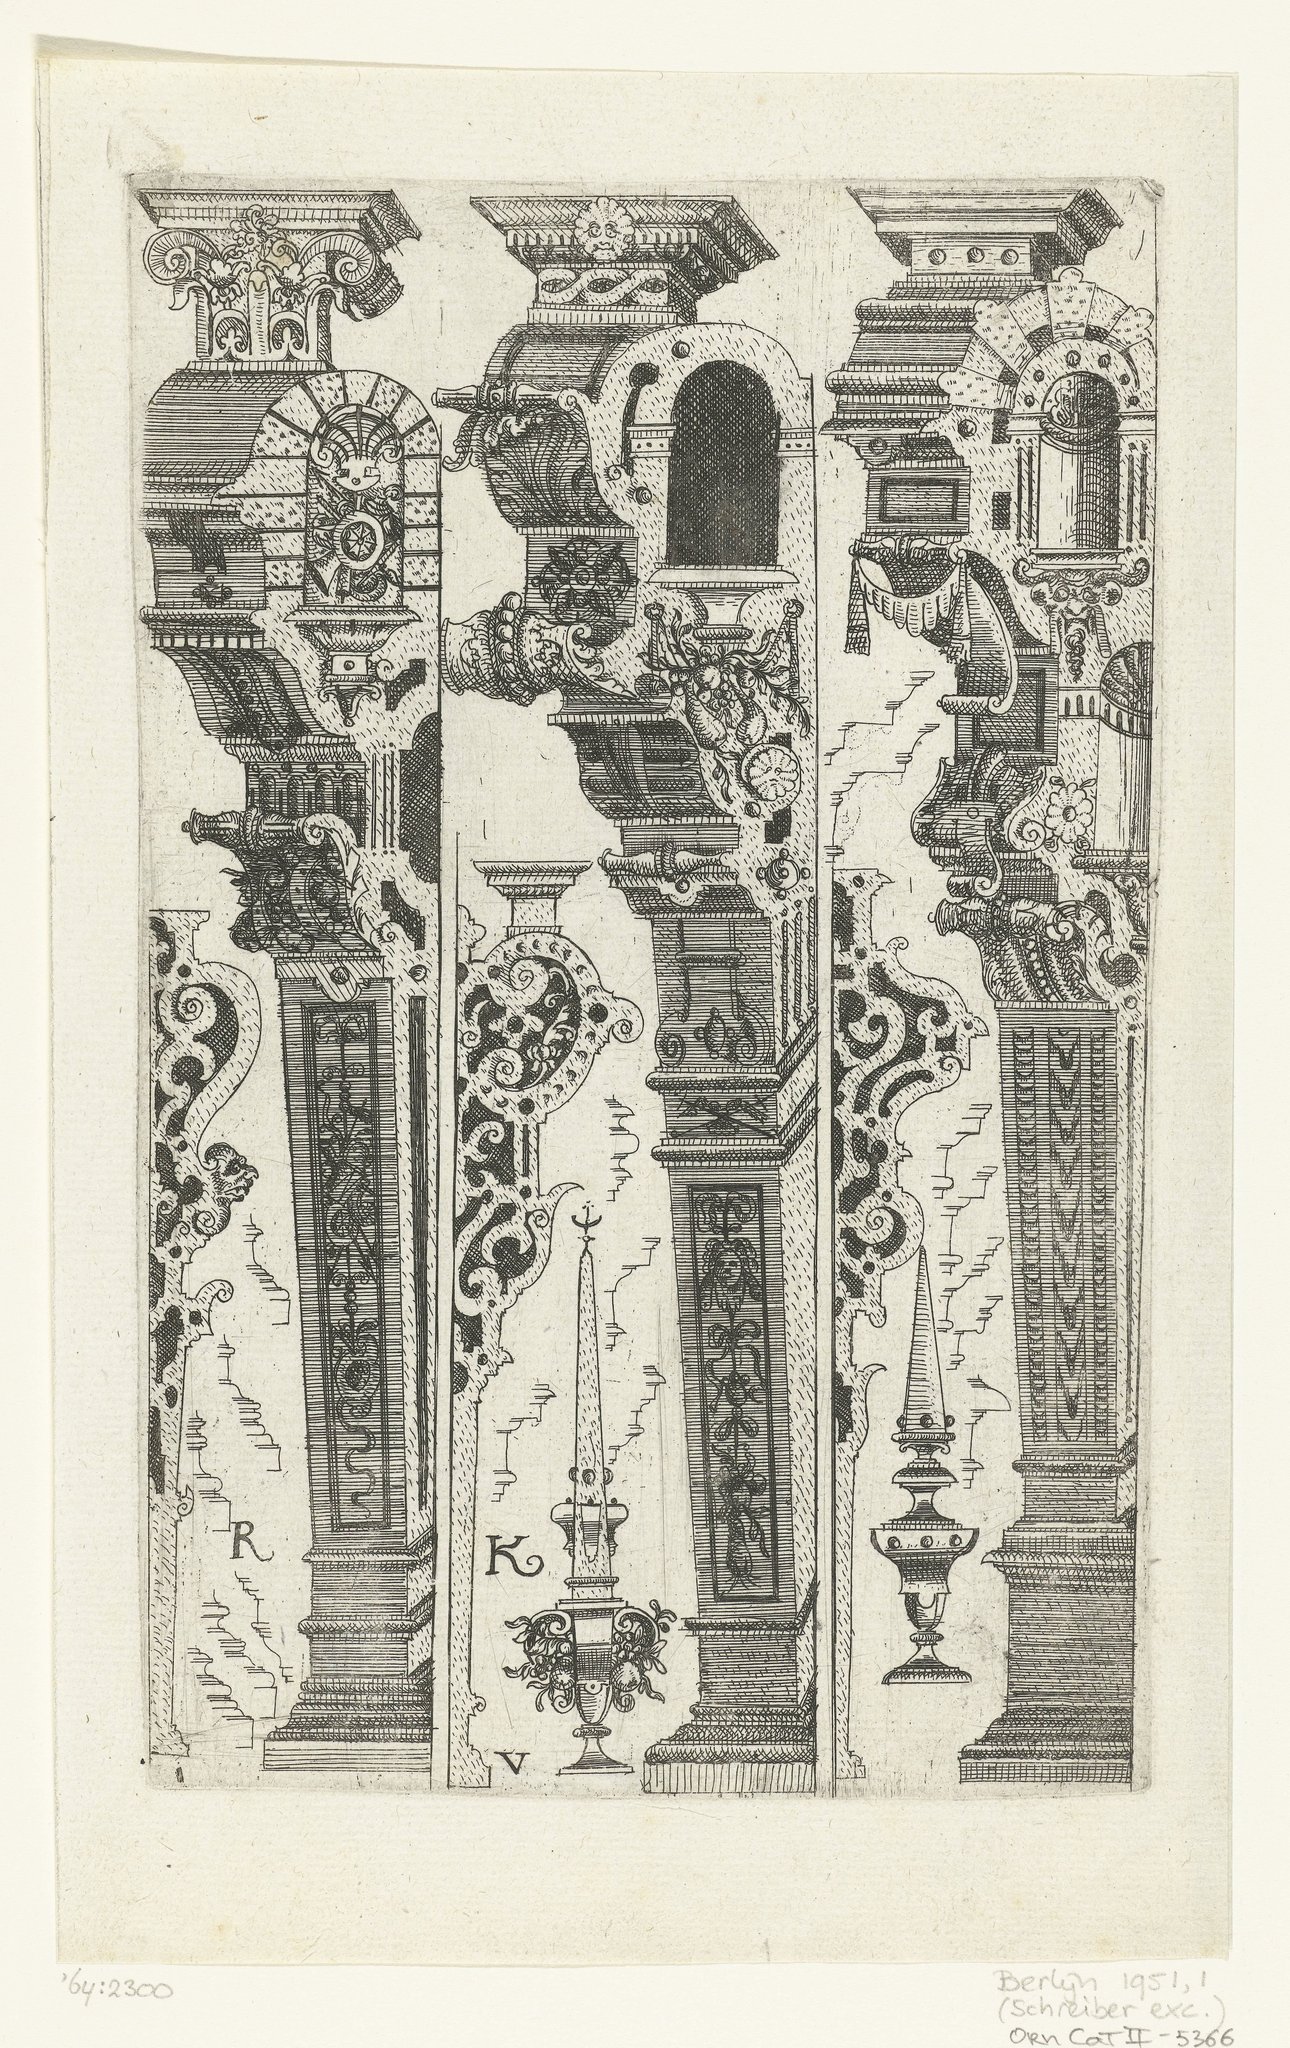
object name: print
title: Drie consoles met fantasiedecoraties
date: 1622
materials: paper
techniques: etching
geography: germany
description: De bovenkant van de consoles is van voren en opzij afgebeeld, de onderkant in perspectief. Naast elke console is een opstand van een kleinere console te zien naast details van voetstukken, kroonlijsten en twee pinakels. Blad V uit tweede editie van serie, bestaande uit 24 bladen.